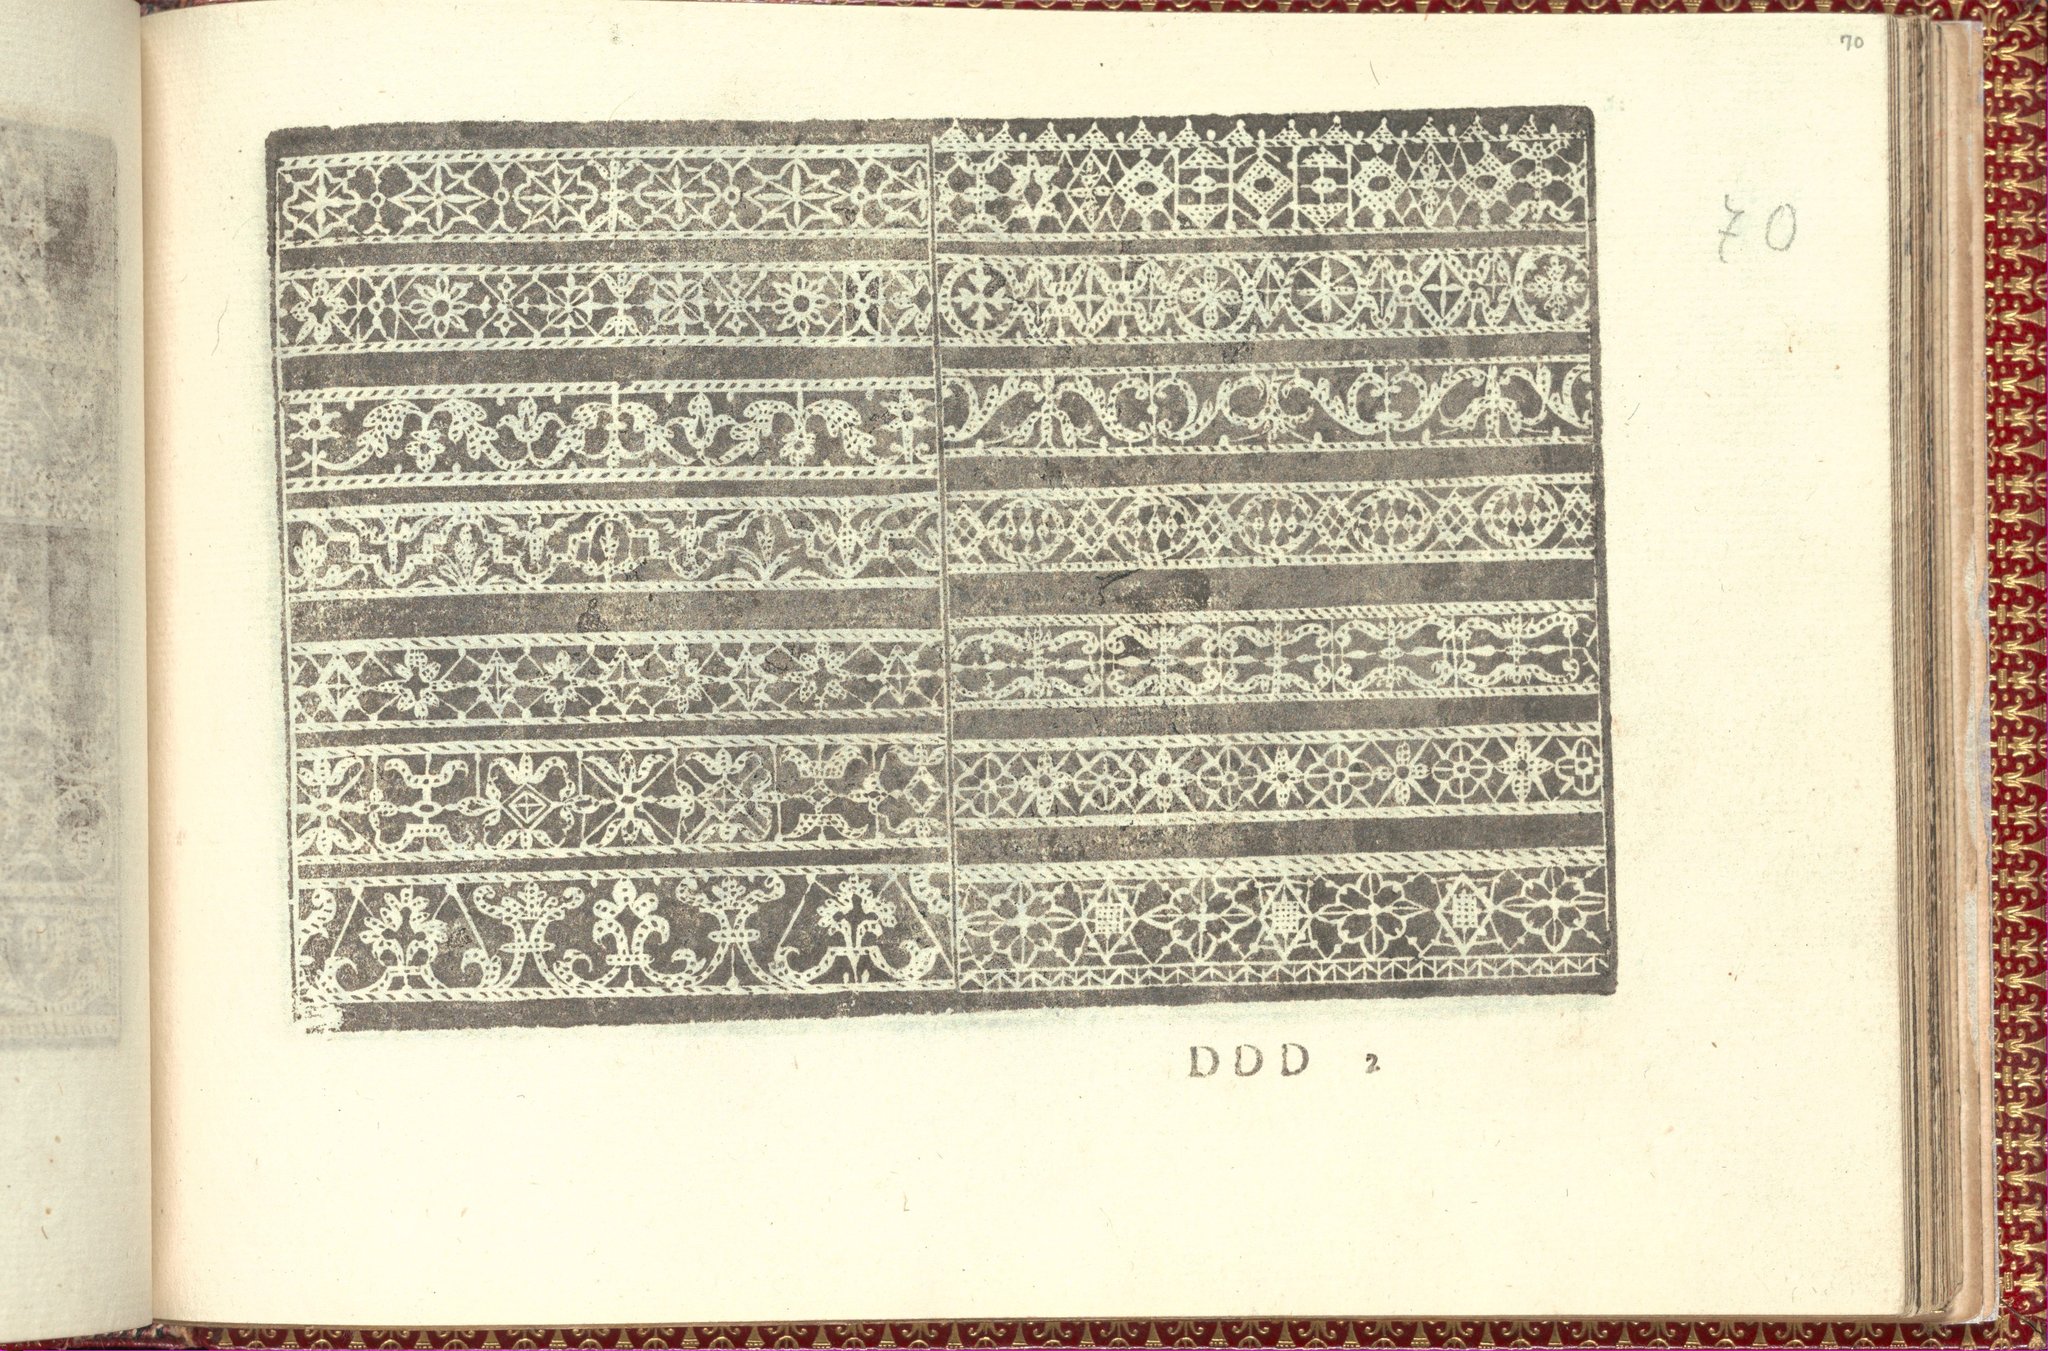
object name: book print ornament architecture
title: Corona delle Nobili et Virtuose Donne: Libro I-IV, page 70 (recto)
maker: cesare vecellio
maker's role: publisher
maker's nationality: italian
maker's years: 1521-1601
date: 1601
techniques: woodcut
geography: italy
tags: flowers